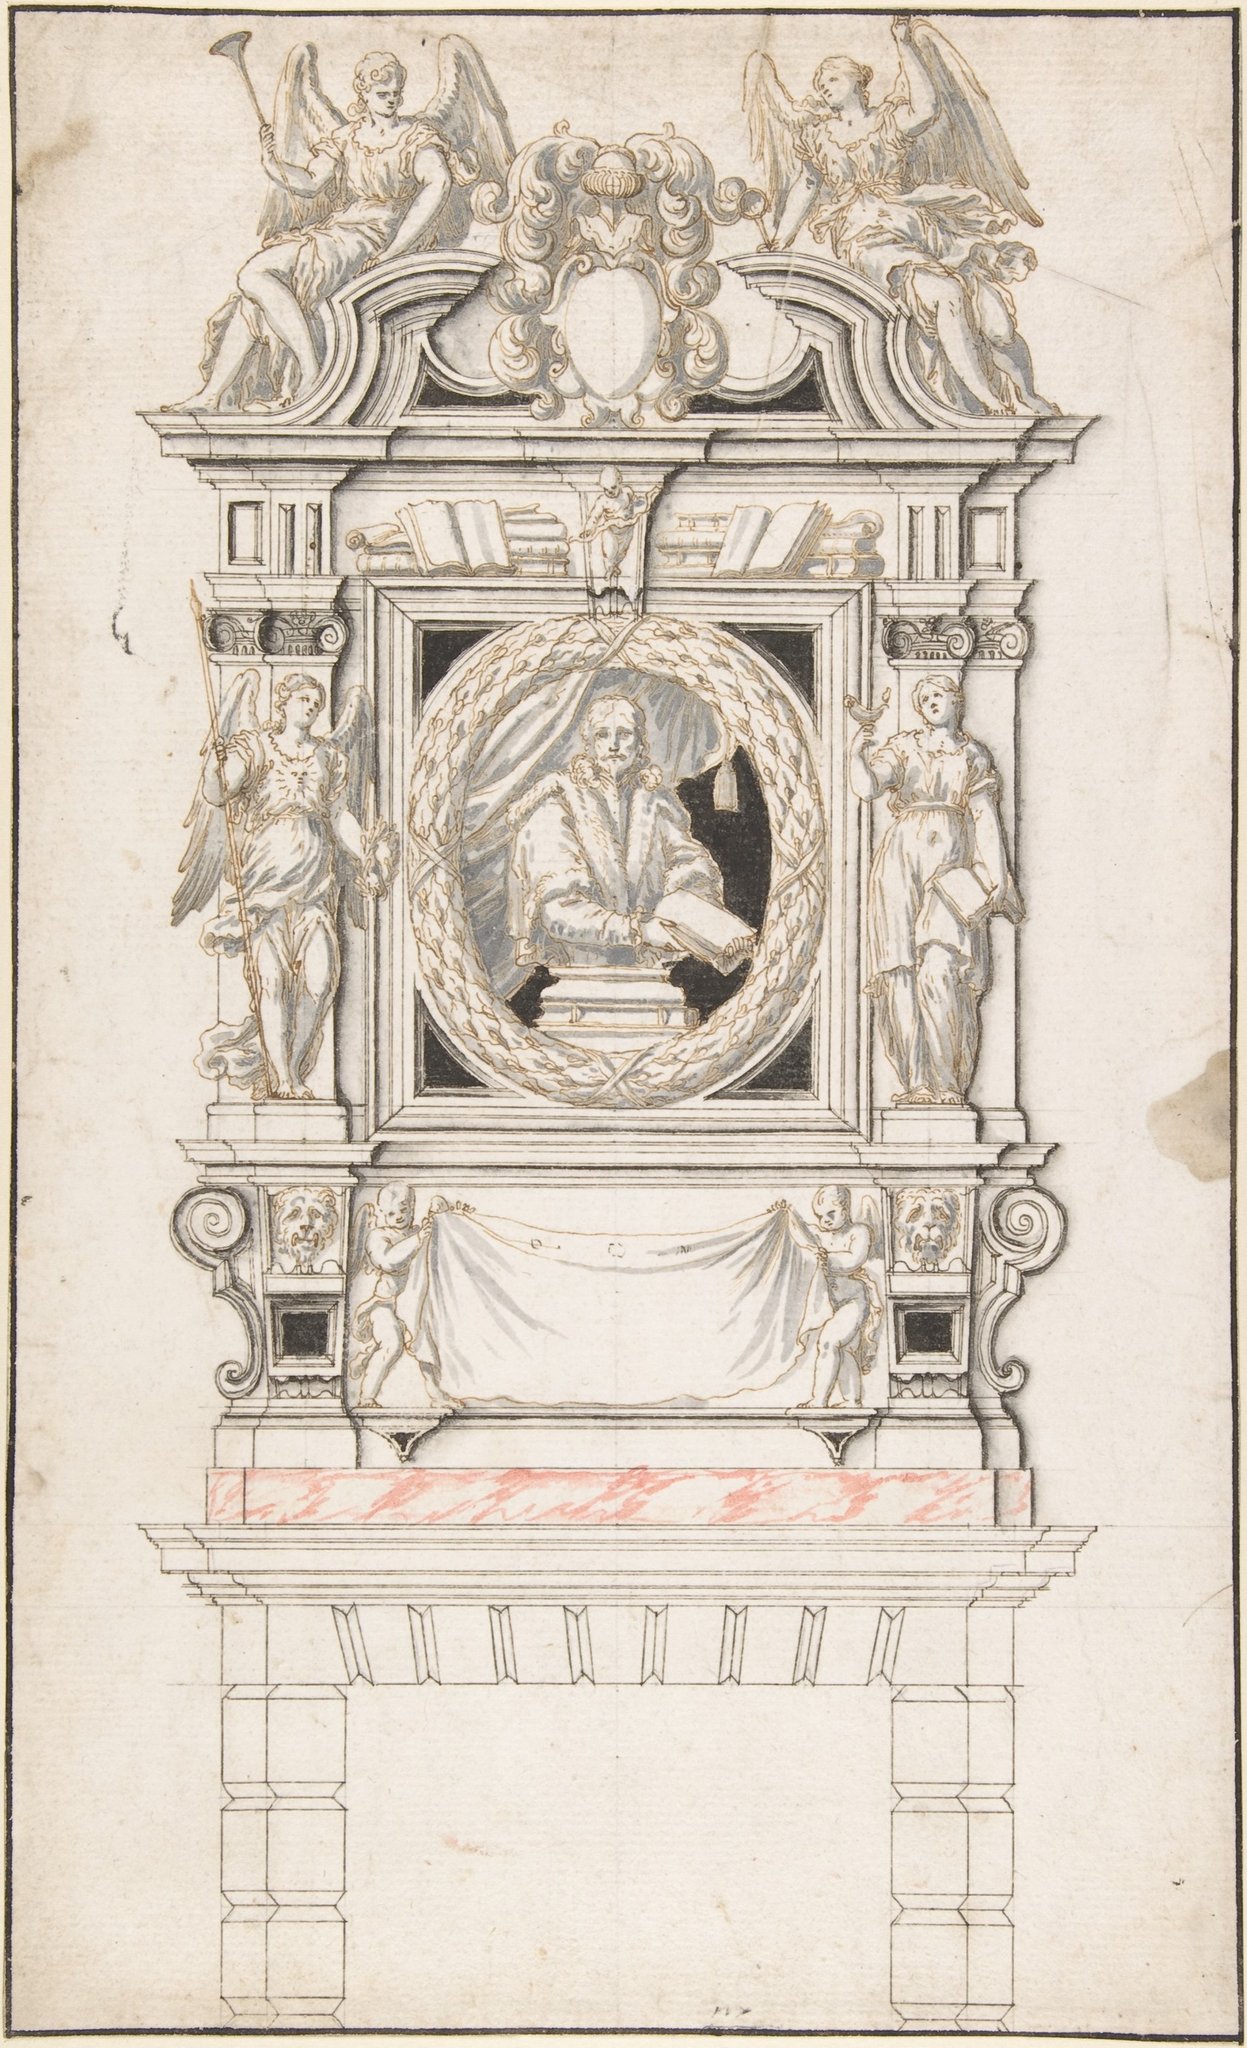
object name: drawing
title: Design for a Wall Tomb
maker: anonymous, french, 17th century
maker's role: artist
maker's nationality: french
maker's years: 1600-1700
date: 1630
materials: ink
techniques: brush, pen, wash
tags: tombs,men